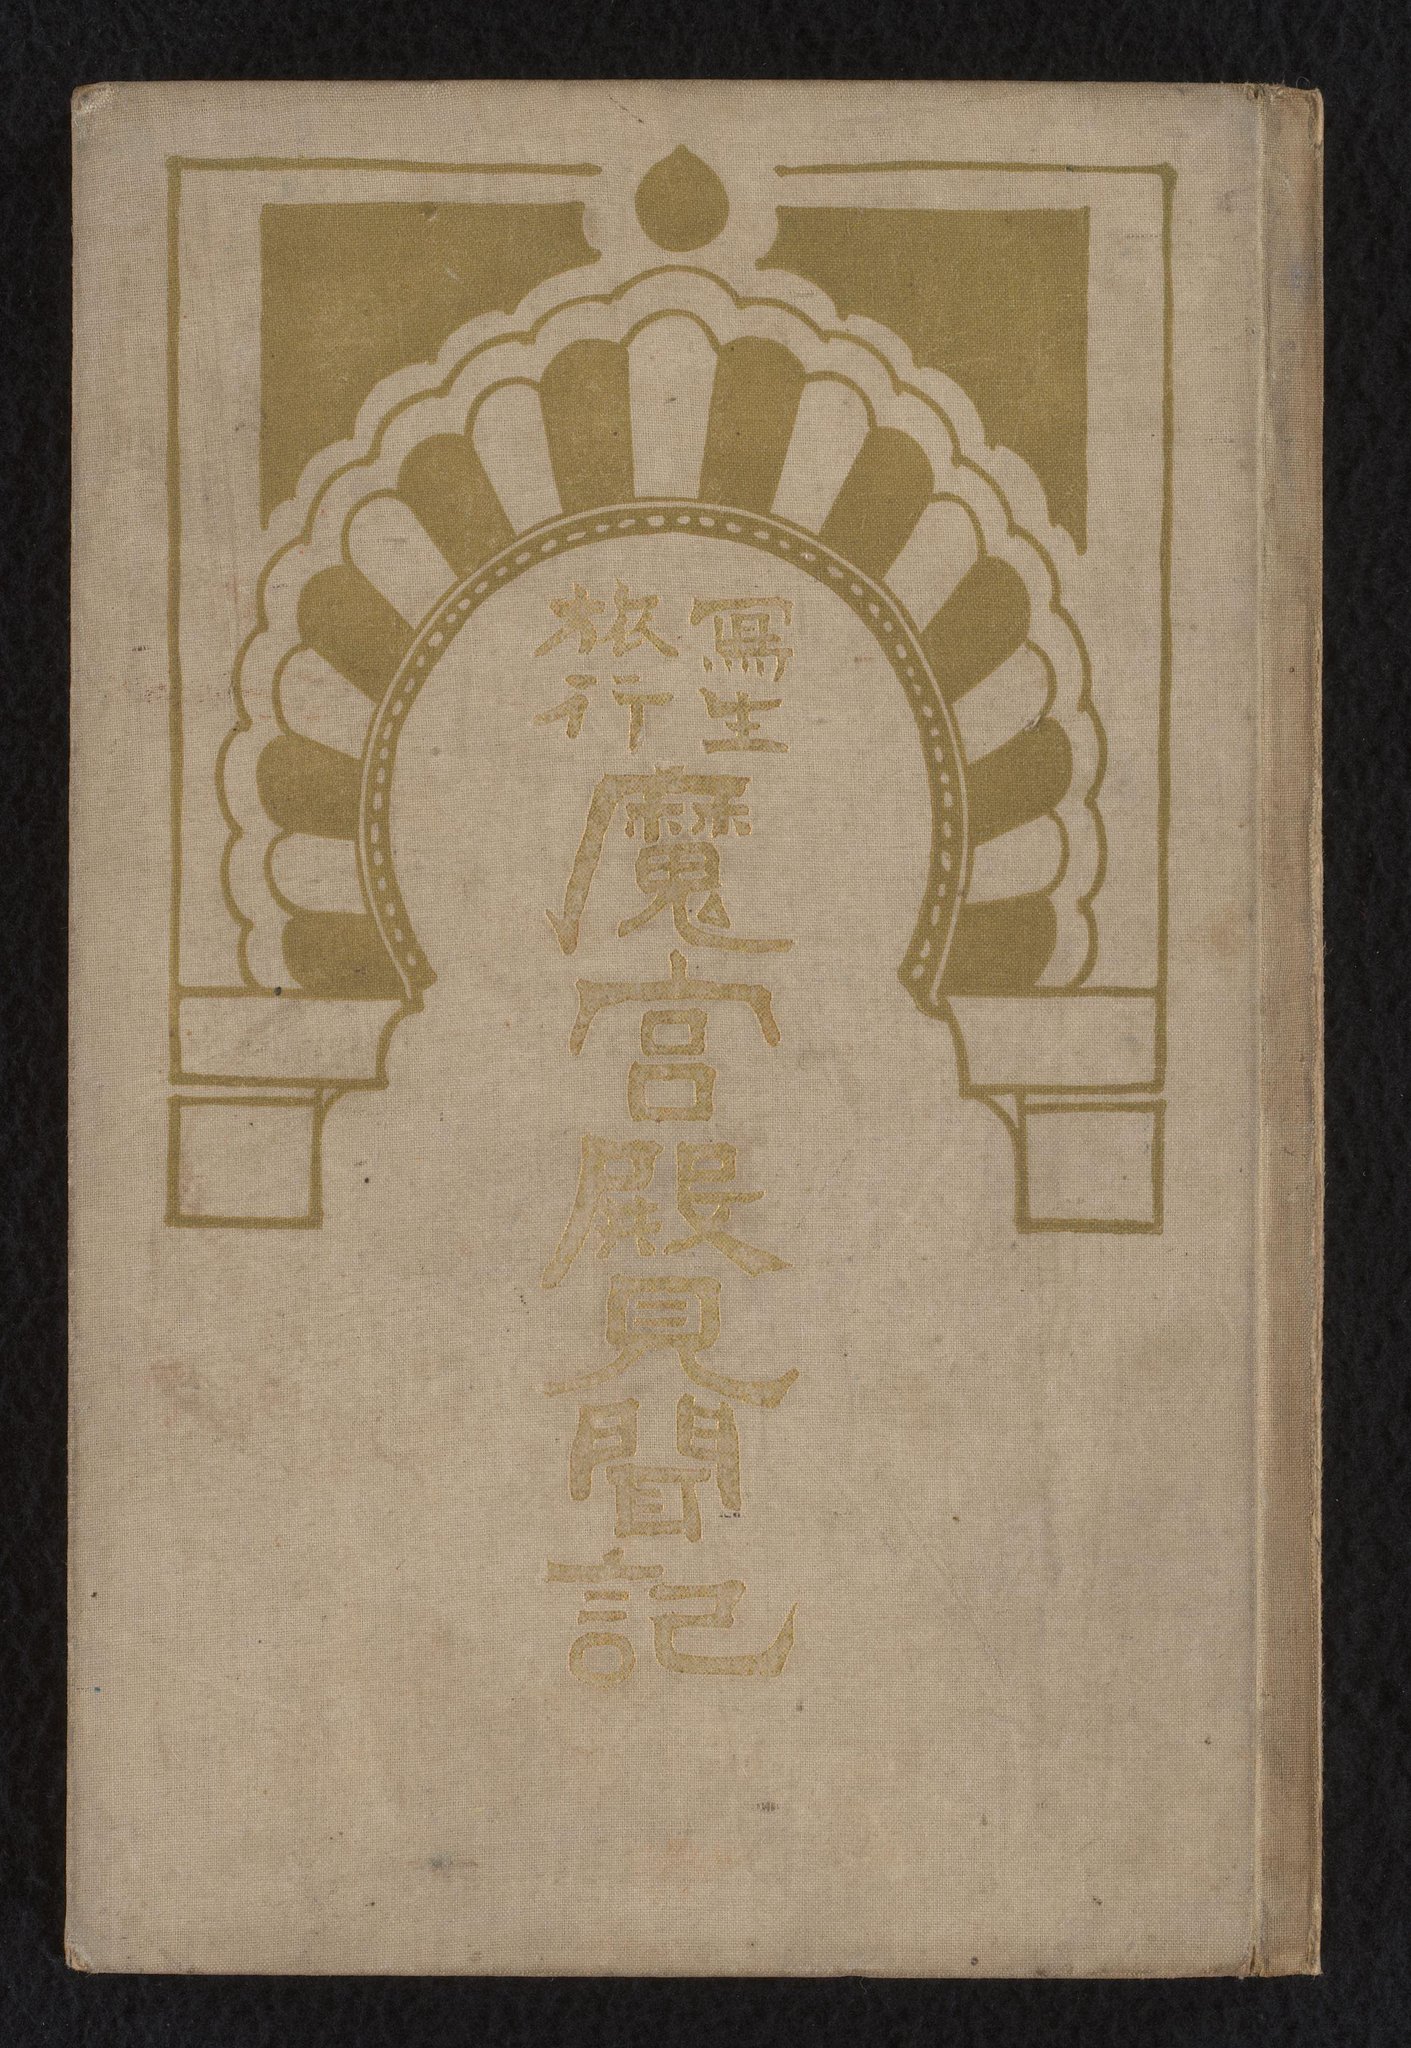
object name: book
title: Shasei ryokô makyuden kenbunki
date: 1910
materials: paper